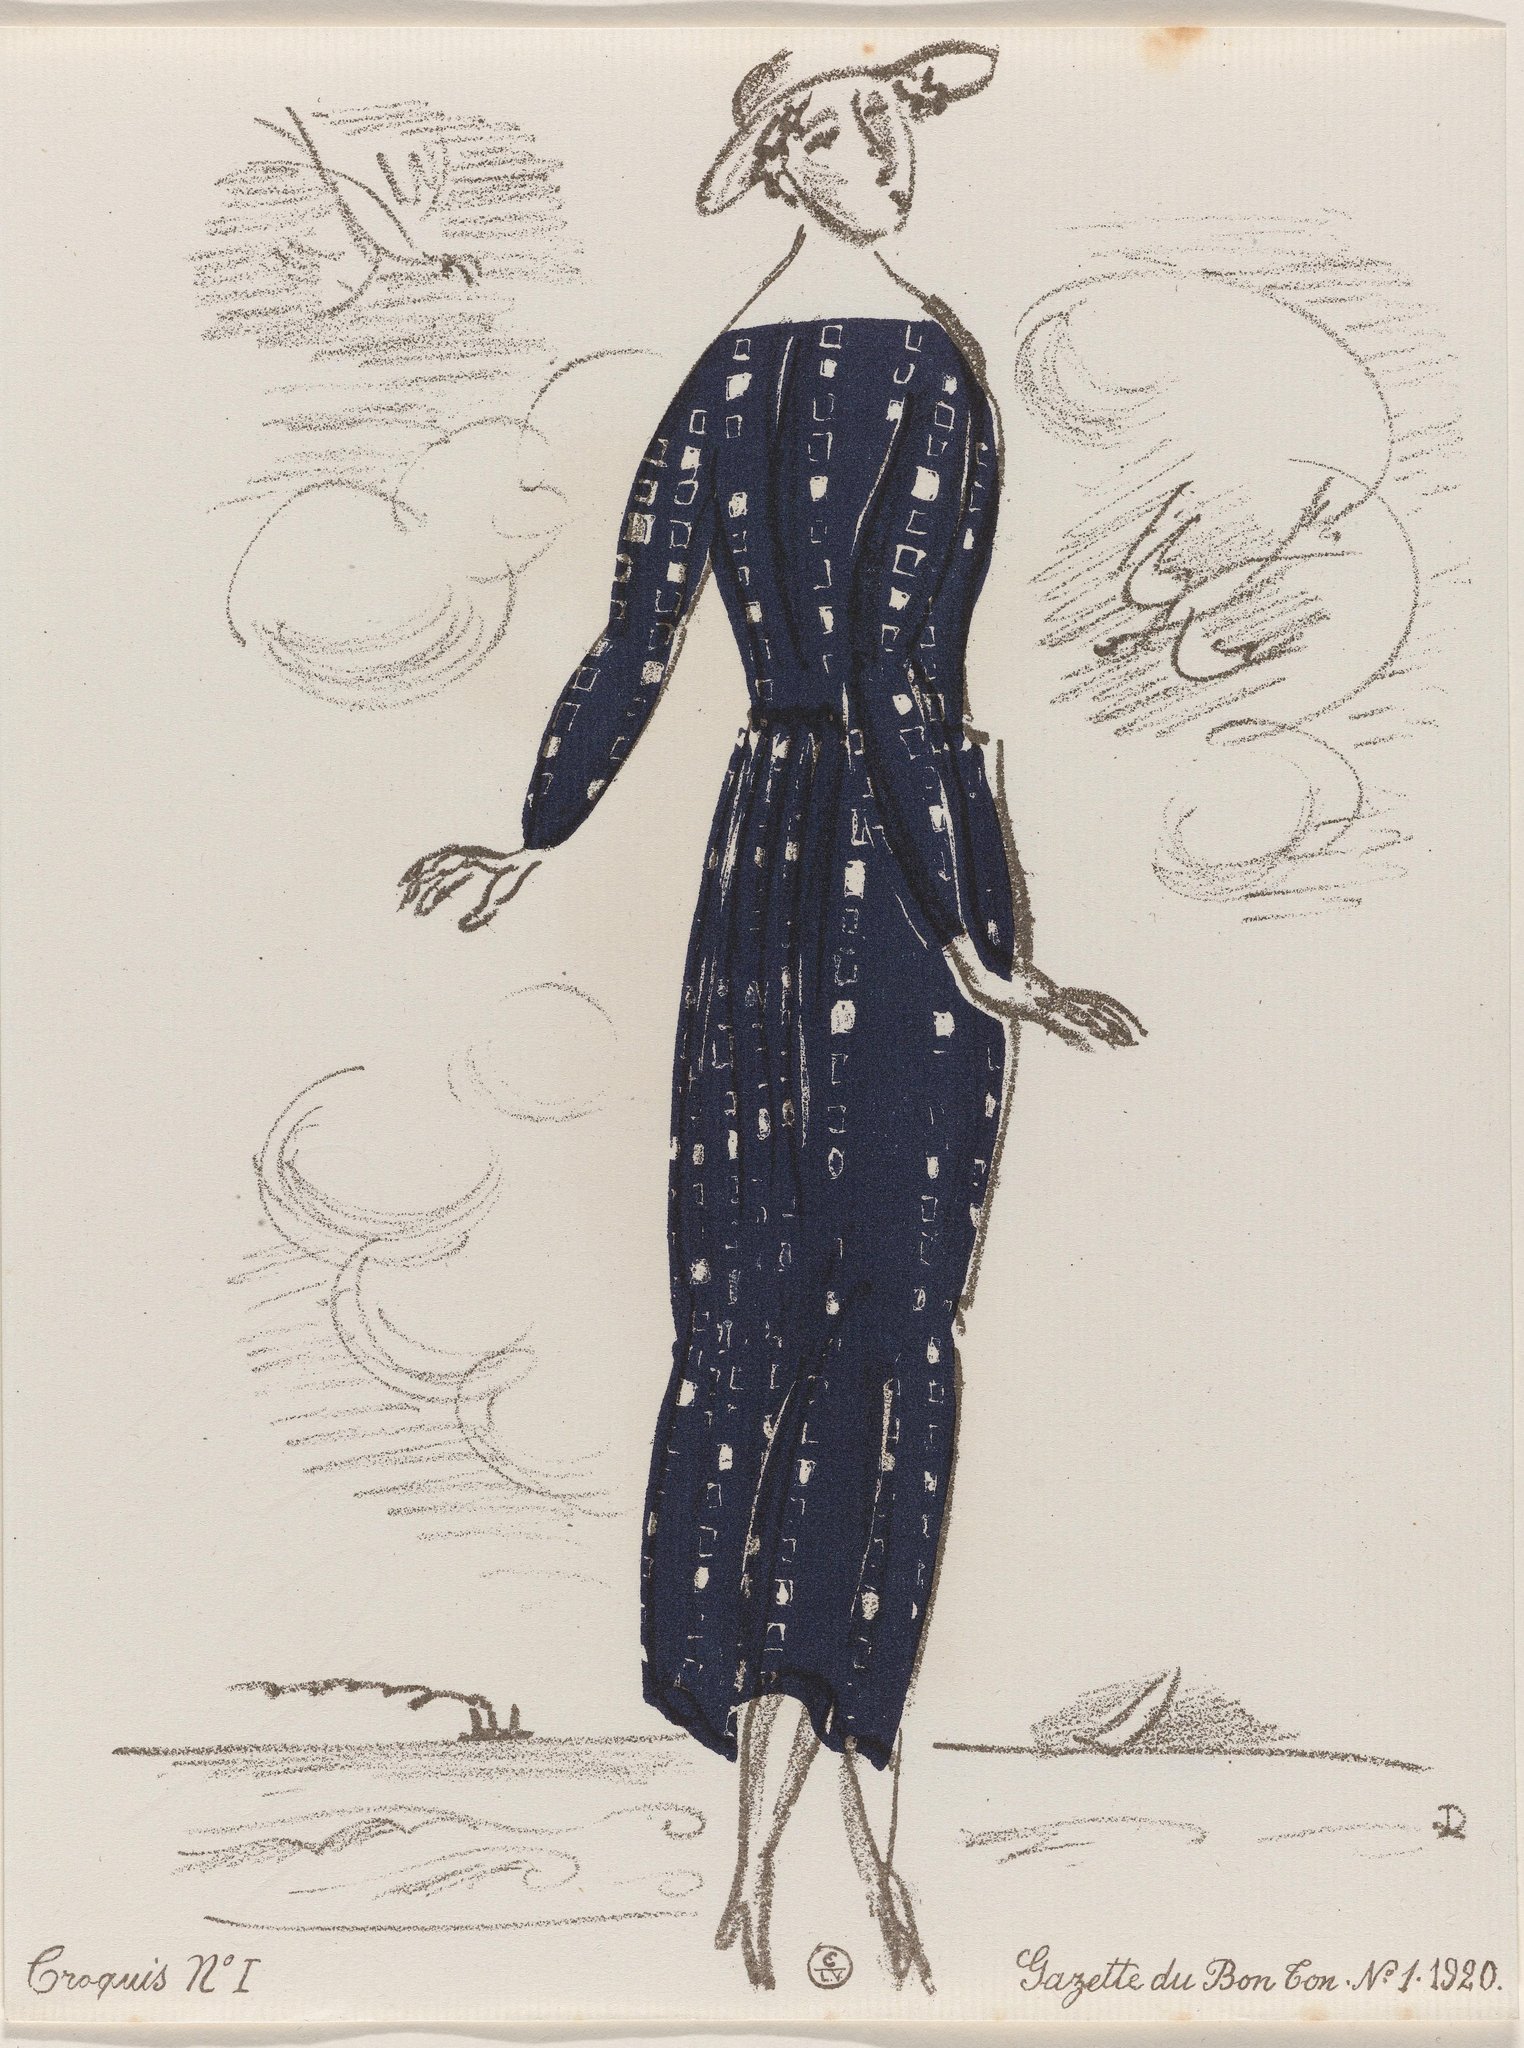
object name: fashion print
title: Fashion Sketches for Summer Gowns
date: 1920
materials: paper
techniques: lithograph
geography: geneva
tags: fashion plates, head-gear: hat (+ women's clothes), dress, gown (+ women's clothes)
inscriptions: inscription: ‘Croquis No I / Gazette du Bon Ton. No 1. 1920’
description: The fabrics of these summer gowns were designed by the artist Raoul Dufy and were produced by the renowned silk manufacturer Bianchini Férier, who employed Dufy as a designer from 1912 until 1928. Their collaboration helped to make Dufy one of the pre-eminent textile designers of the 20th century. One of the cloaks is a creation by Poiret.